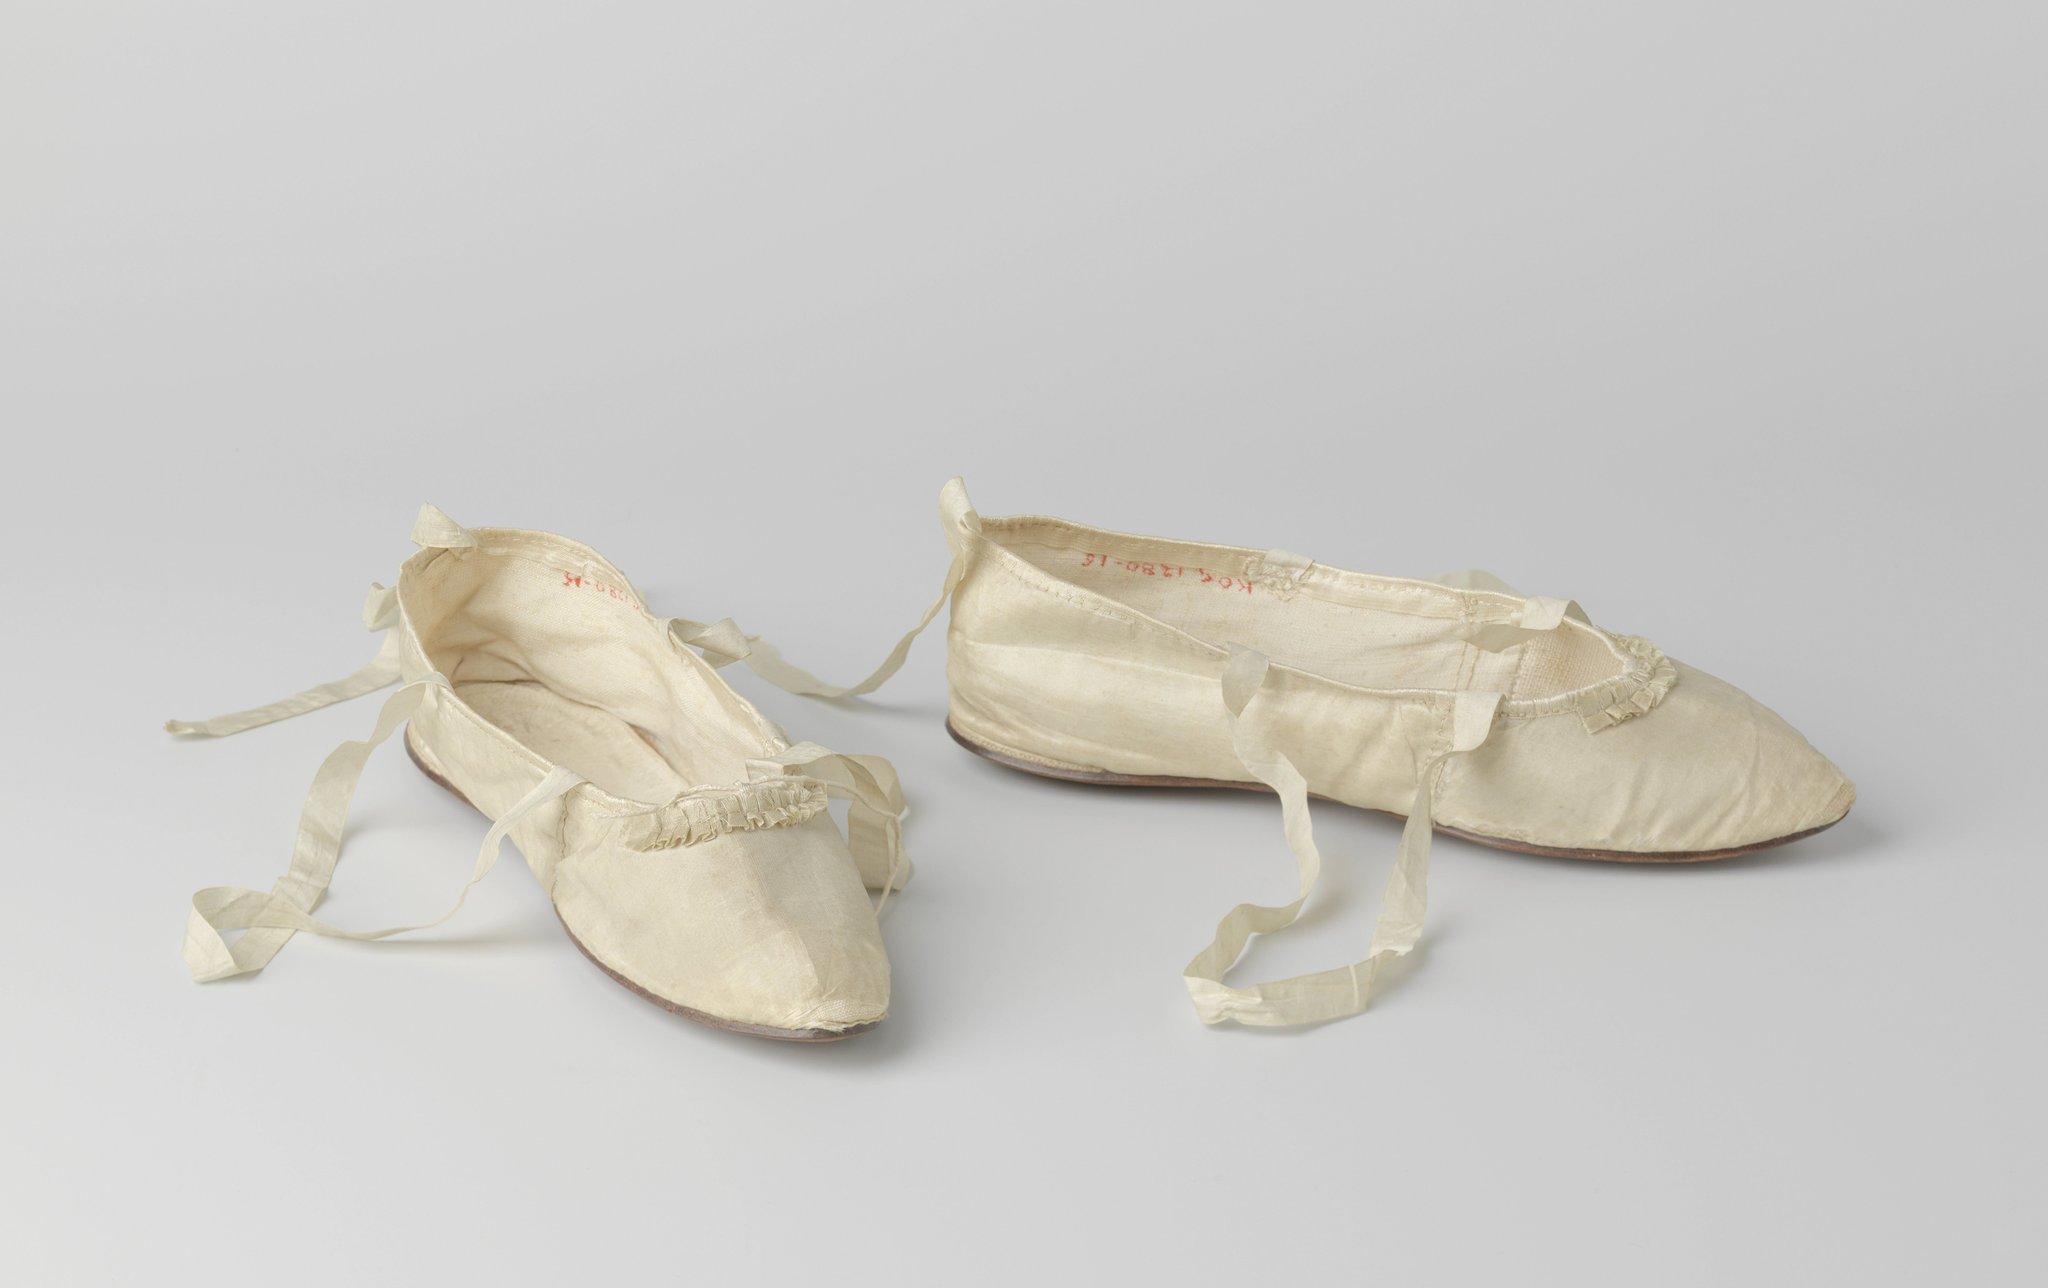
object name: shoe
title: Schoen van witte tafzijde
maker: Anonymous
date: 1800-1810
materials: silk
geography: northern netherlands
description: Schoen van witte tafzijde. Geen links/rechts verschil. Doorlopende puntige zool, geen hak, smalle ruche langs het uitgesneden voorblad. Kruisbandjes van lint. Zool van leer